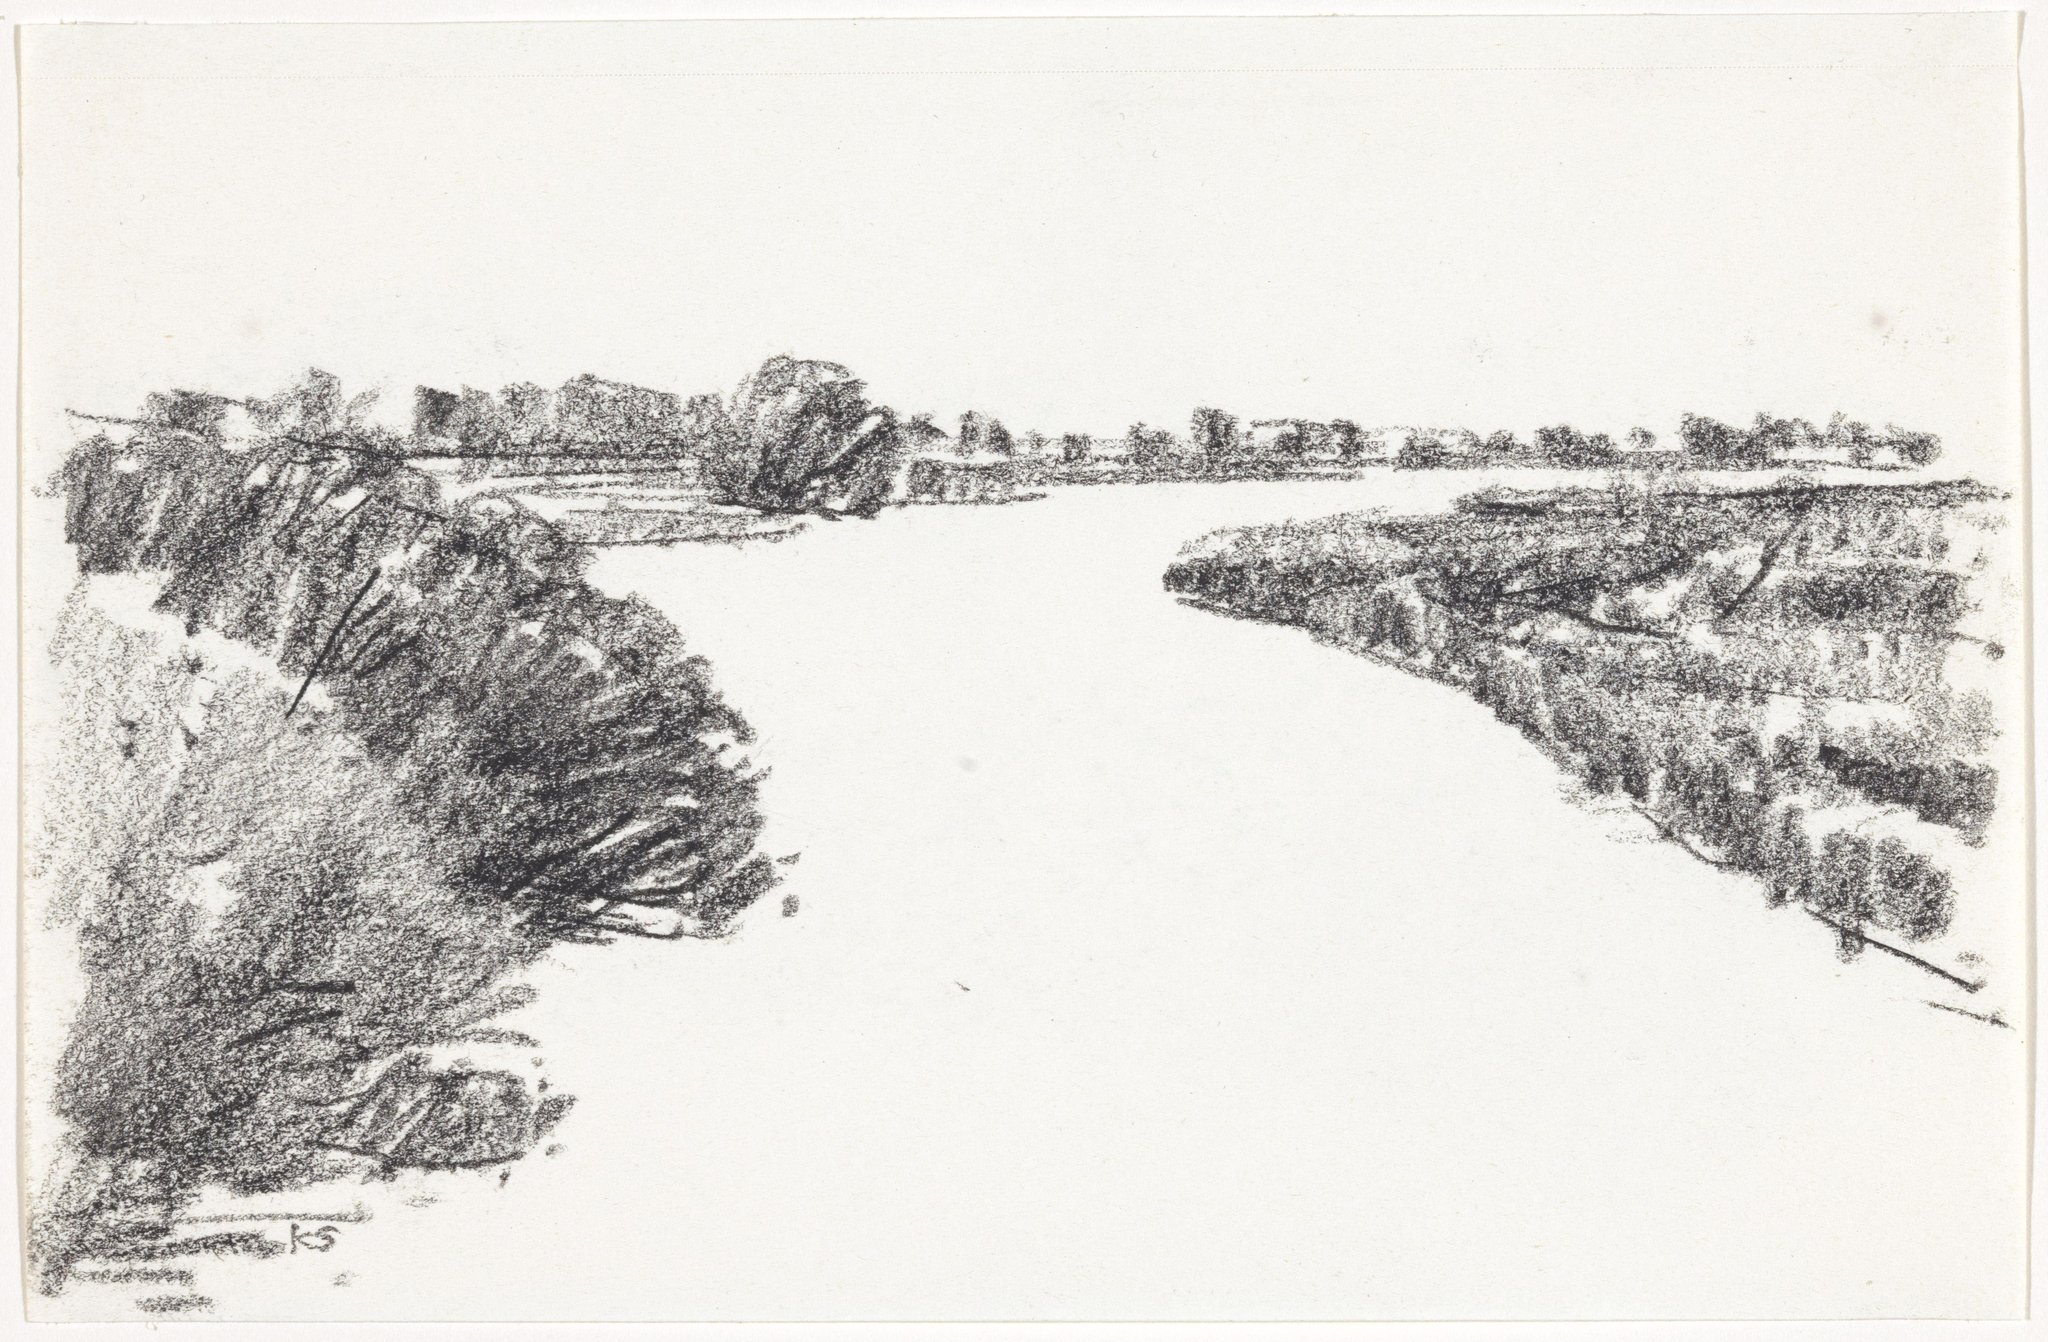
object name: drawing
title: Meanderende rivier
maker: kees stoop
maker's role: draughtsman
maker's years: 1929-2019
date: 1939-2009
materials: charcoal, paper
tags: river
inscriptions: signature: ‘KS’